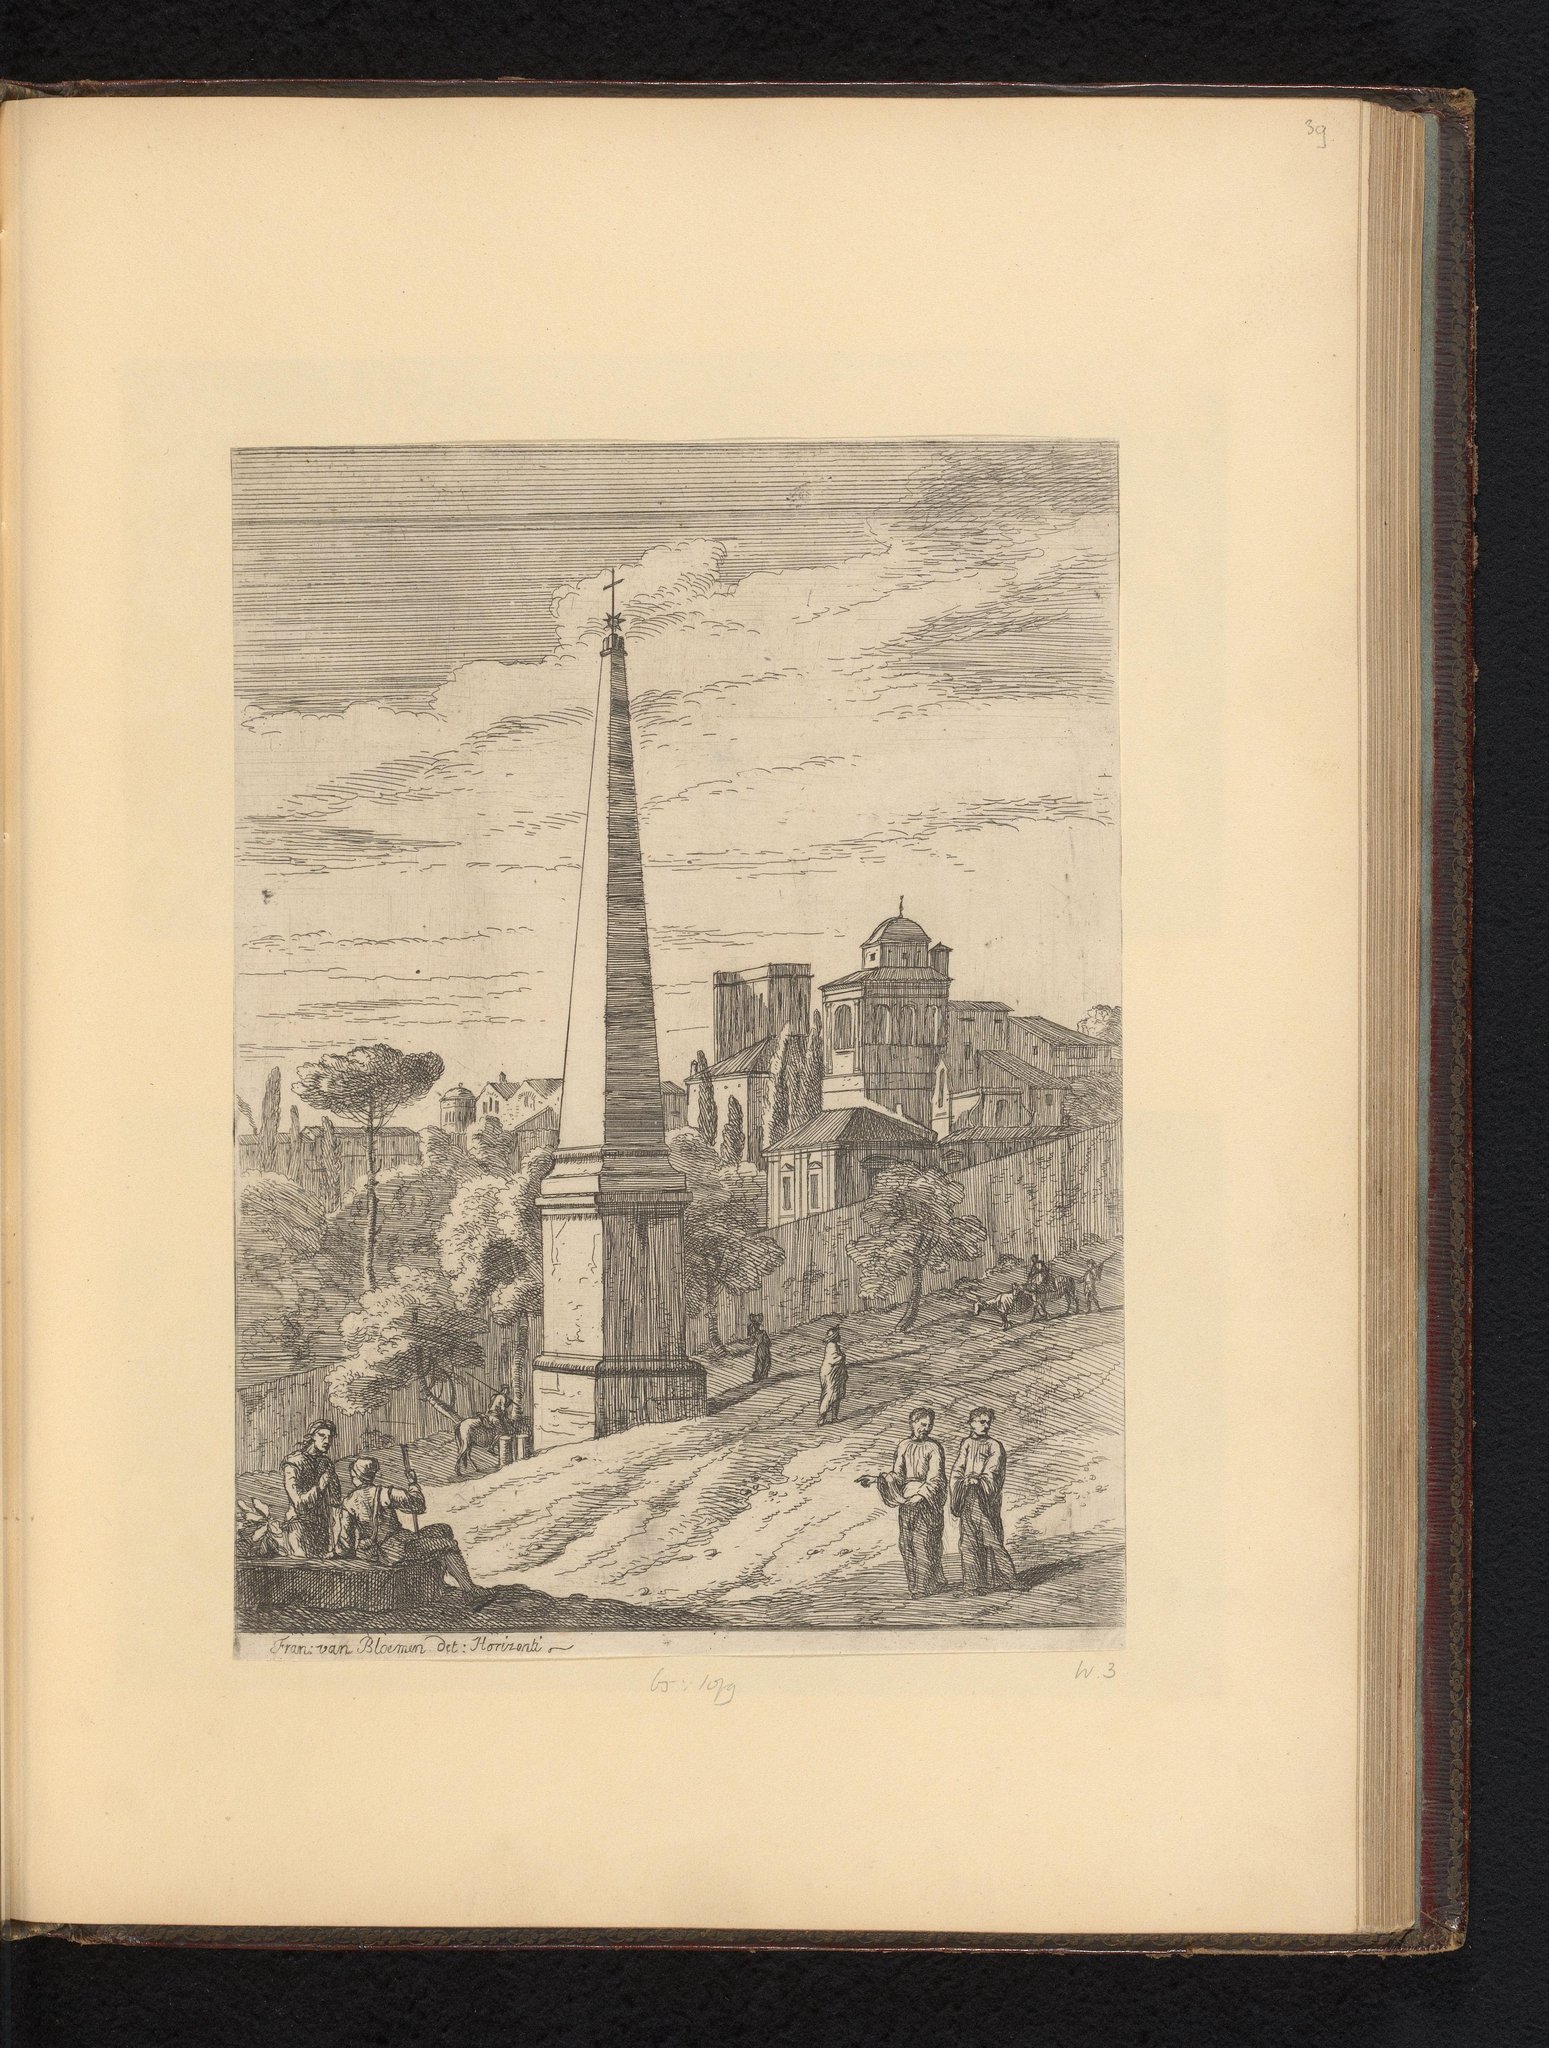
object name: print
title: Stadsgezicht met een obelisk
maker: jan frans van bloemen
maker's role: draughtsman, print maker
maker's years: 1662-1749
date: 1672-1749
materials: paper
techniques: etching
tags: obelisk, needle, city-view in general; 'veduta' (+ city(-scape) with figures, staffage)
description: Prent maakt mogelijk deel uit van een serie van 200 prenten. Deze serie is onder de titel 'A Collection of two hundred original etchings' voor het eerst uitgegeven door J.M. Greery in 1816.